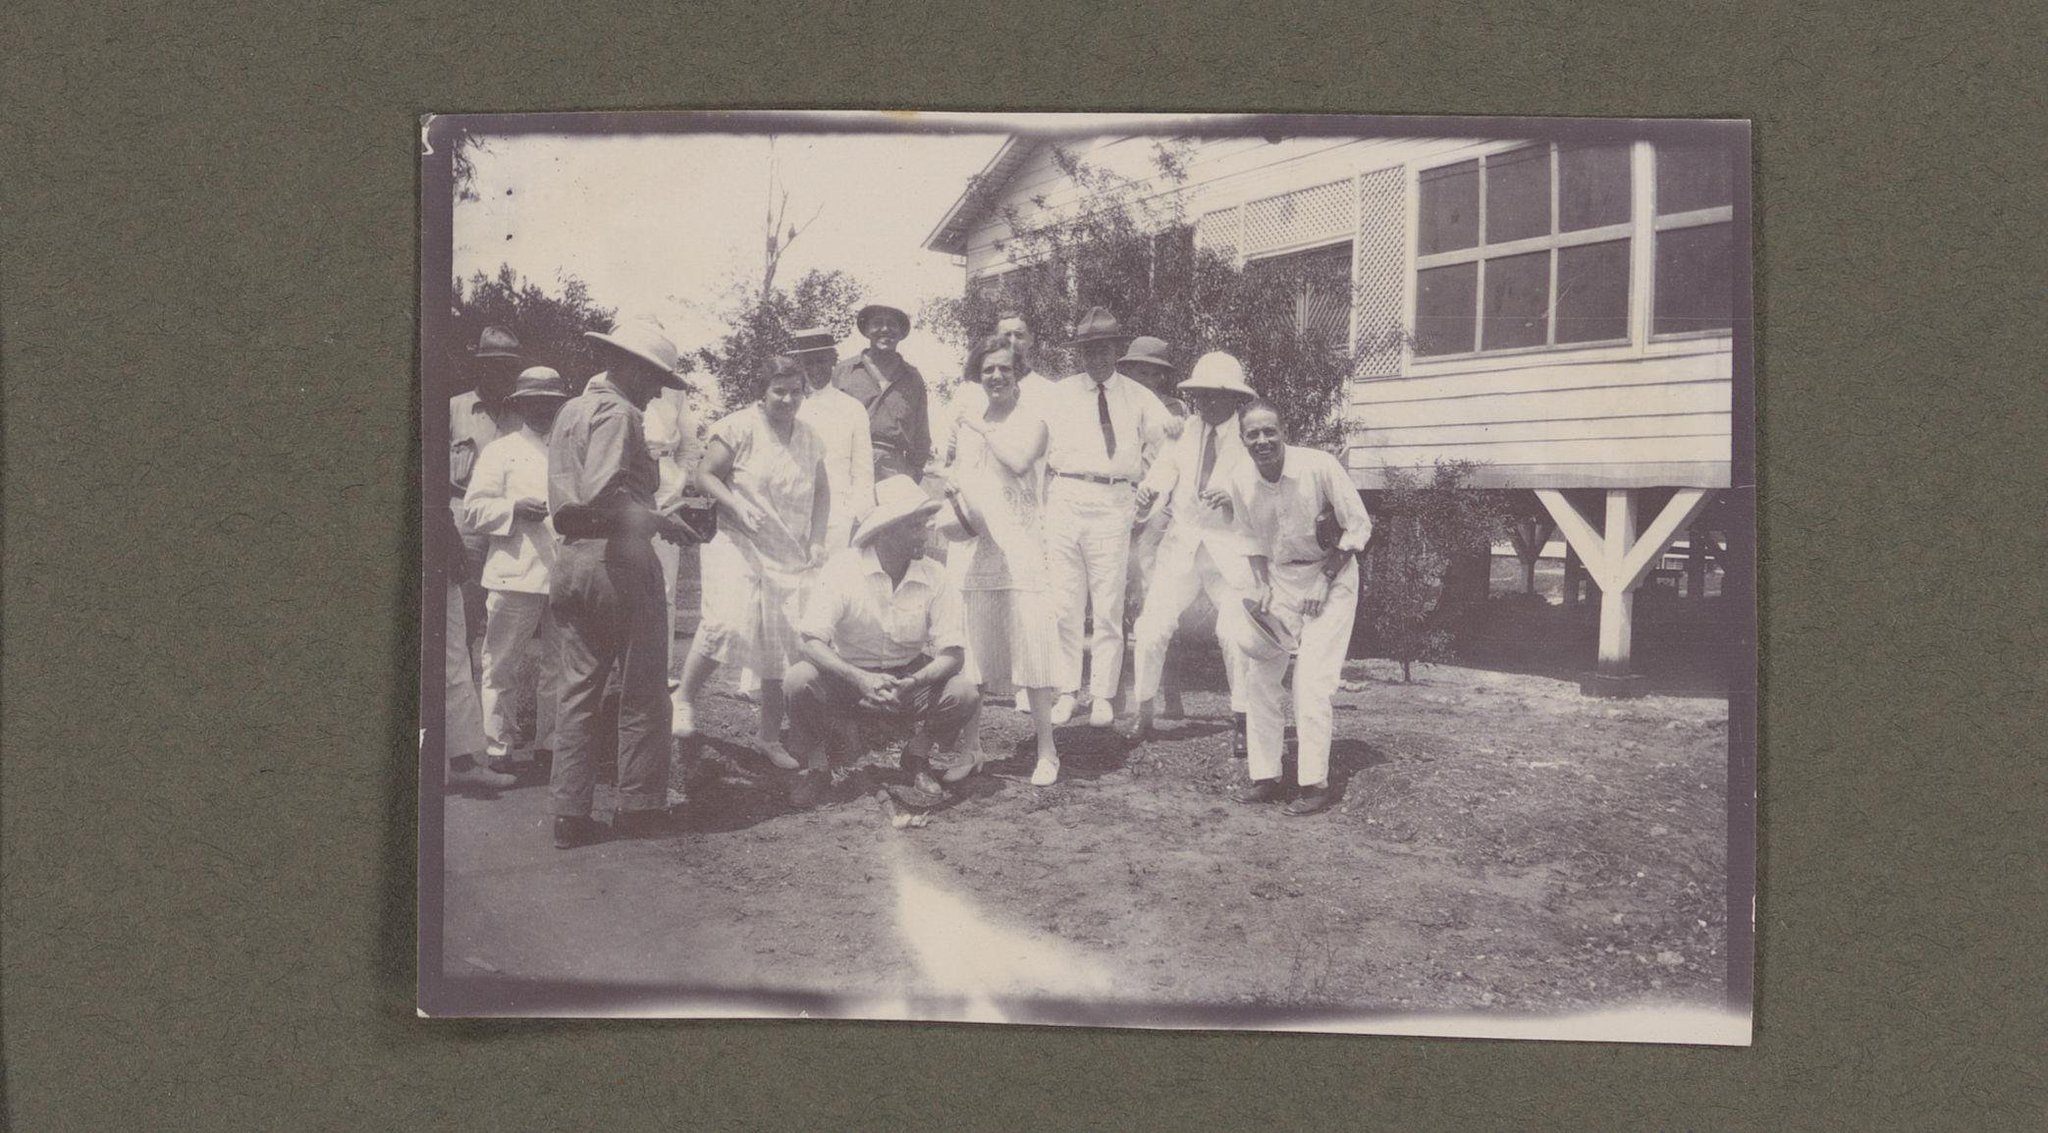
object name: photograph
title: Groepsfoto voor een huis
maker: Anonymous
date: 1925-1927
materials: photographic support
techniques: photography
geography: suriname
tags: jetten, familie, moengo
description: Groepsfoto voor een huis, waarschijnlijk te Moengo. Foto op een bladzijde van een los albumblad. Onderdeel van het ensemble met foto's van de familie van ingenieur Jetten in de mijnbouwstad Moengo in Suriname.